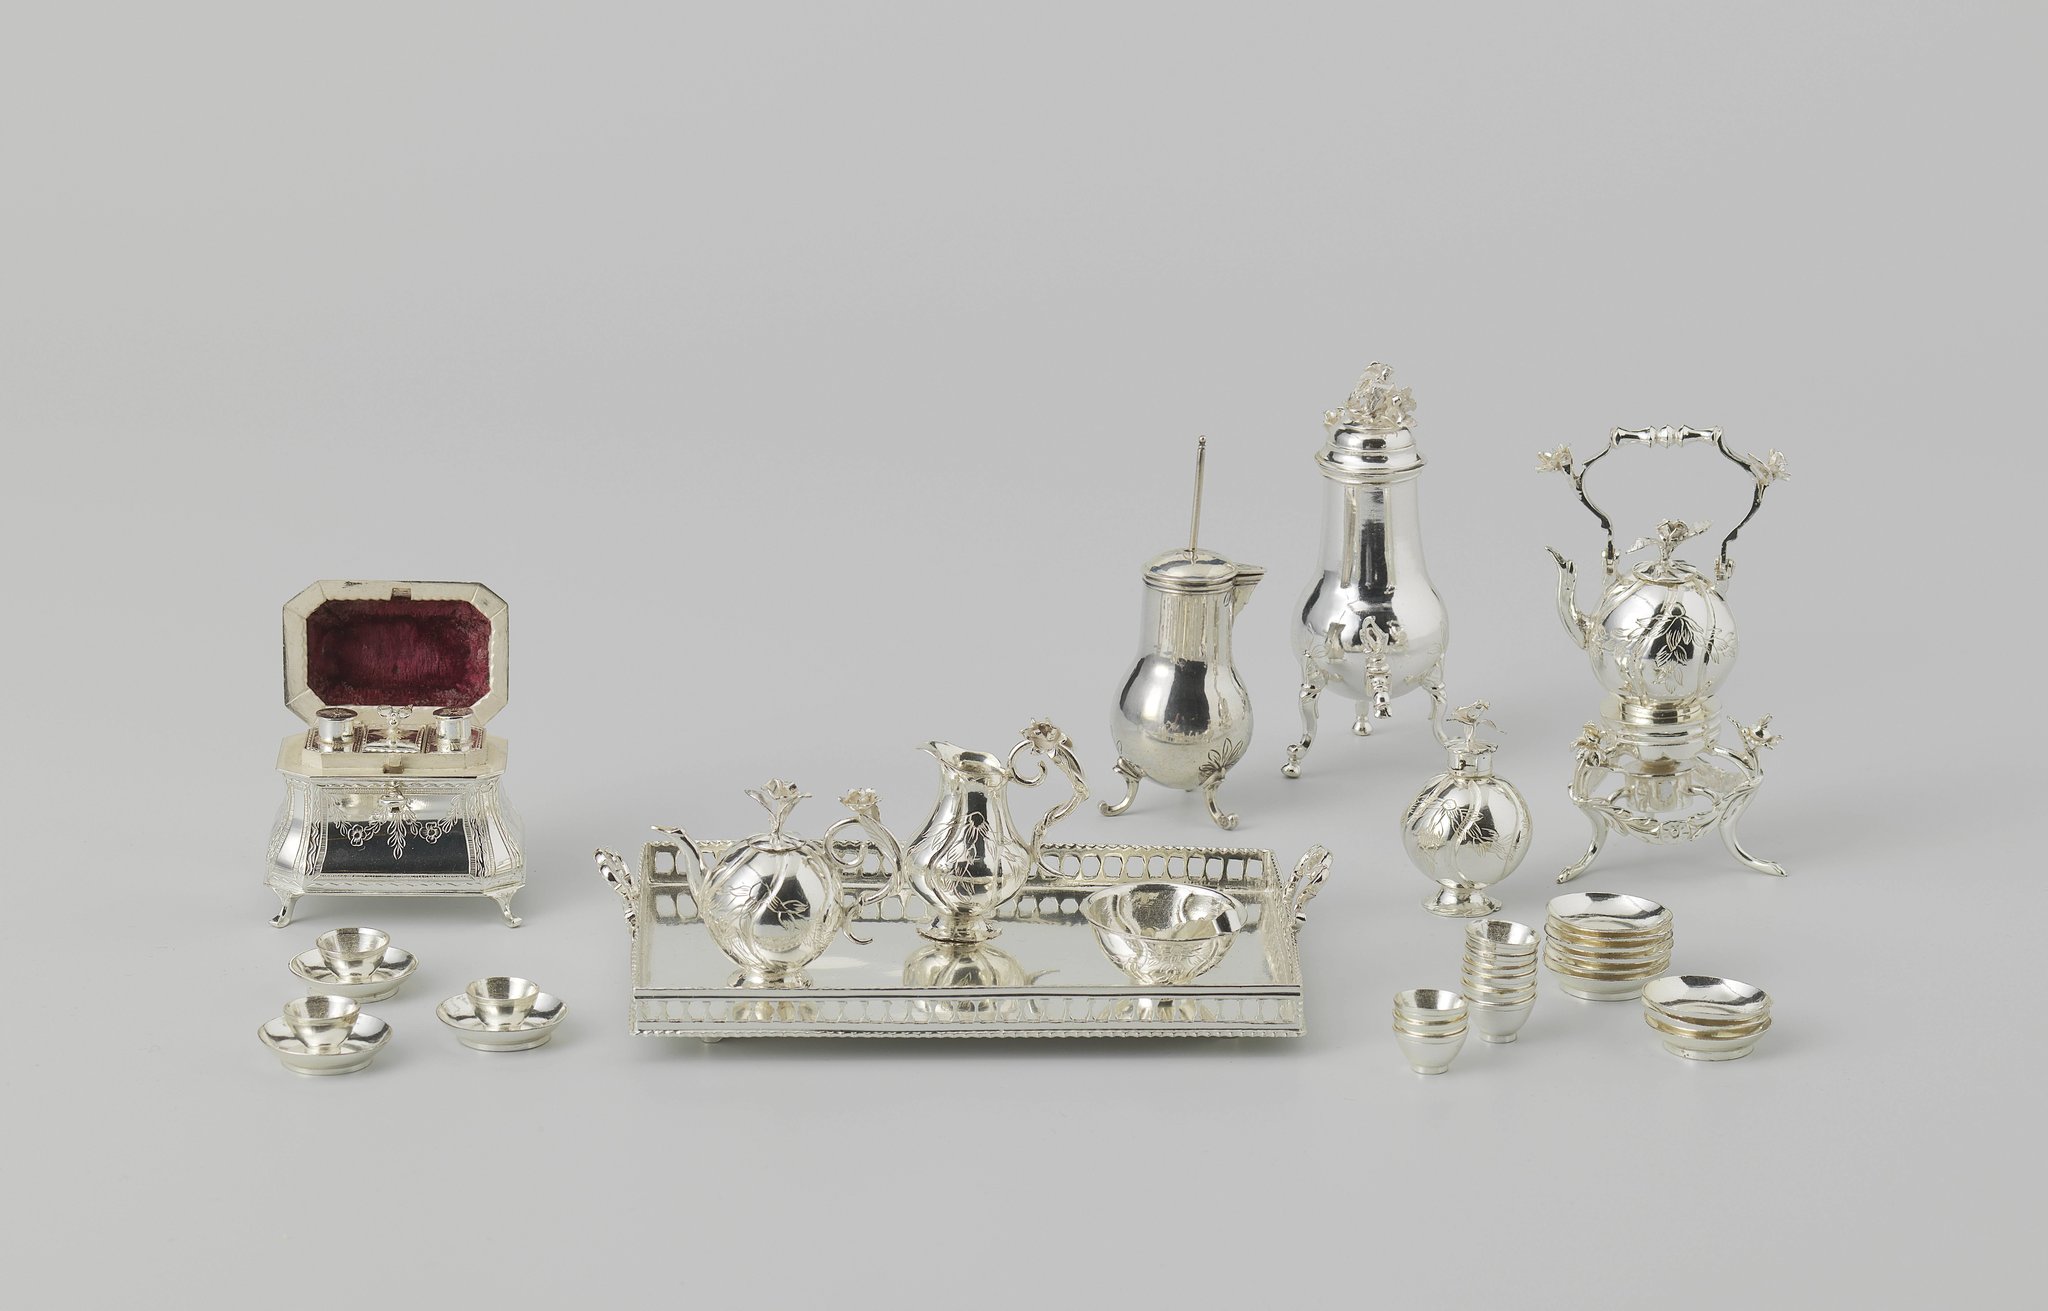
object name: miniature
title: Komfoor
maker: jan bonket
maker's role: silversmith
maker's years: 1727-1789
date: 1778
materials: silver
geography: amsterdam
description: Komfoor op s-vormige poten. Bovenaan de poten zijn bloemen bevestigd die soortgelijk zijn aan de bloemen van de bijbehorende ketel. Tussen de poten lopen guirlandes. Het komfoor is niet gemerkt.